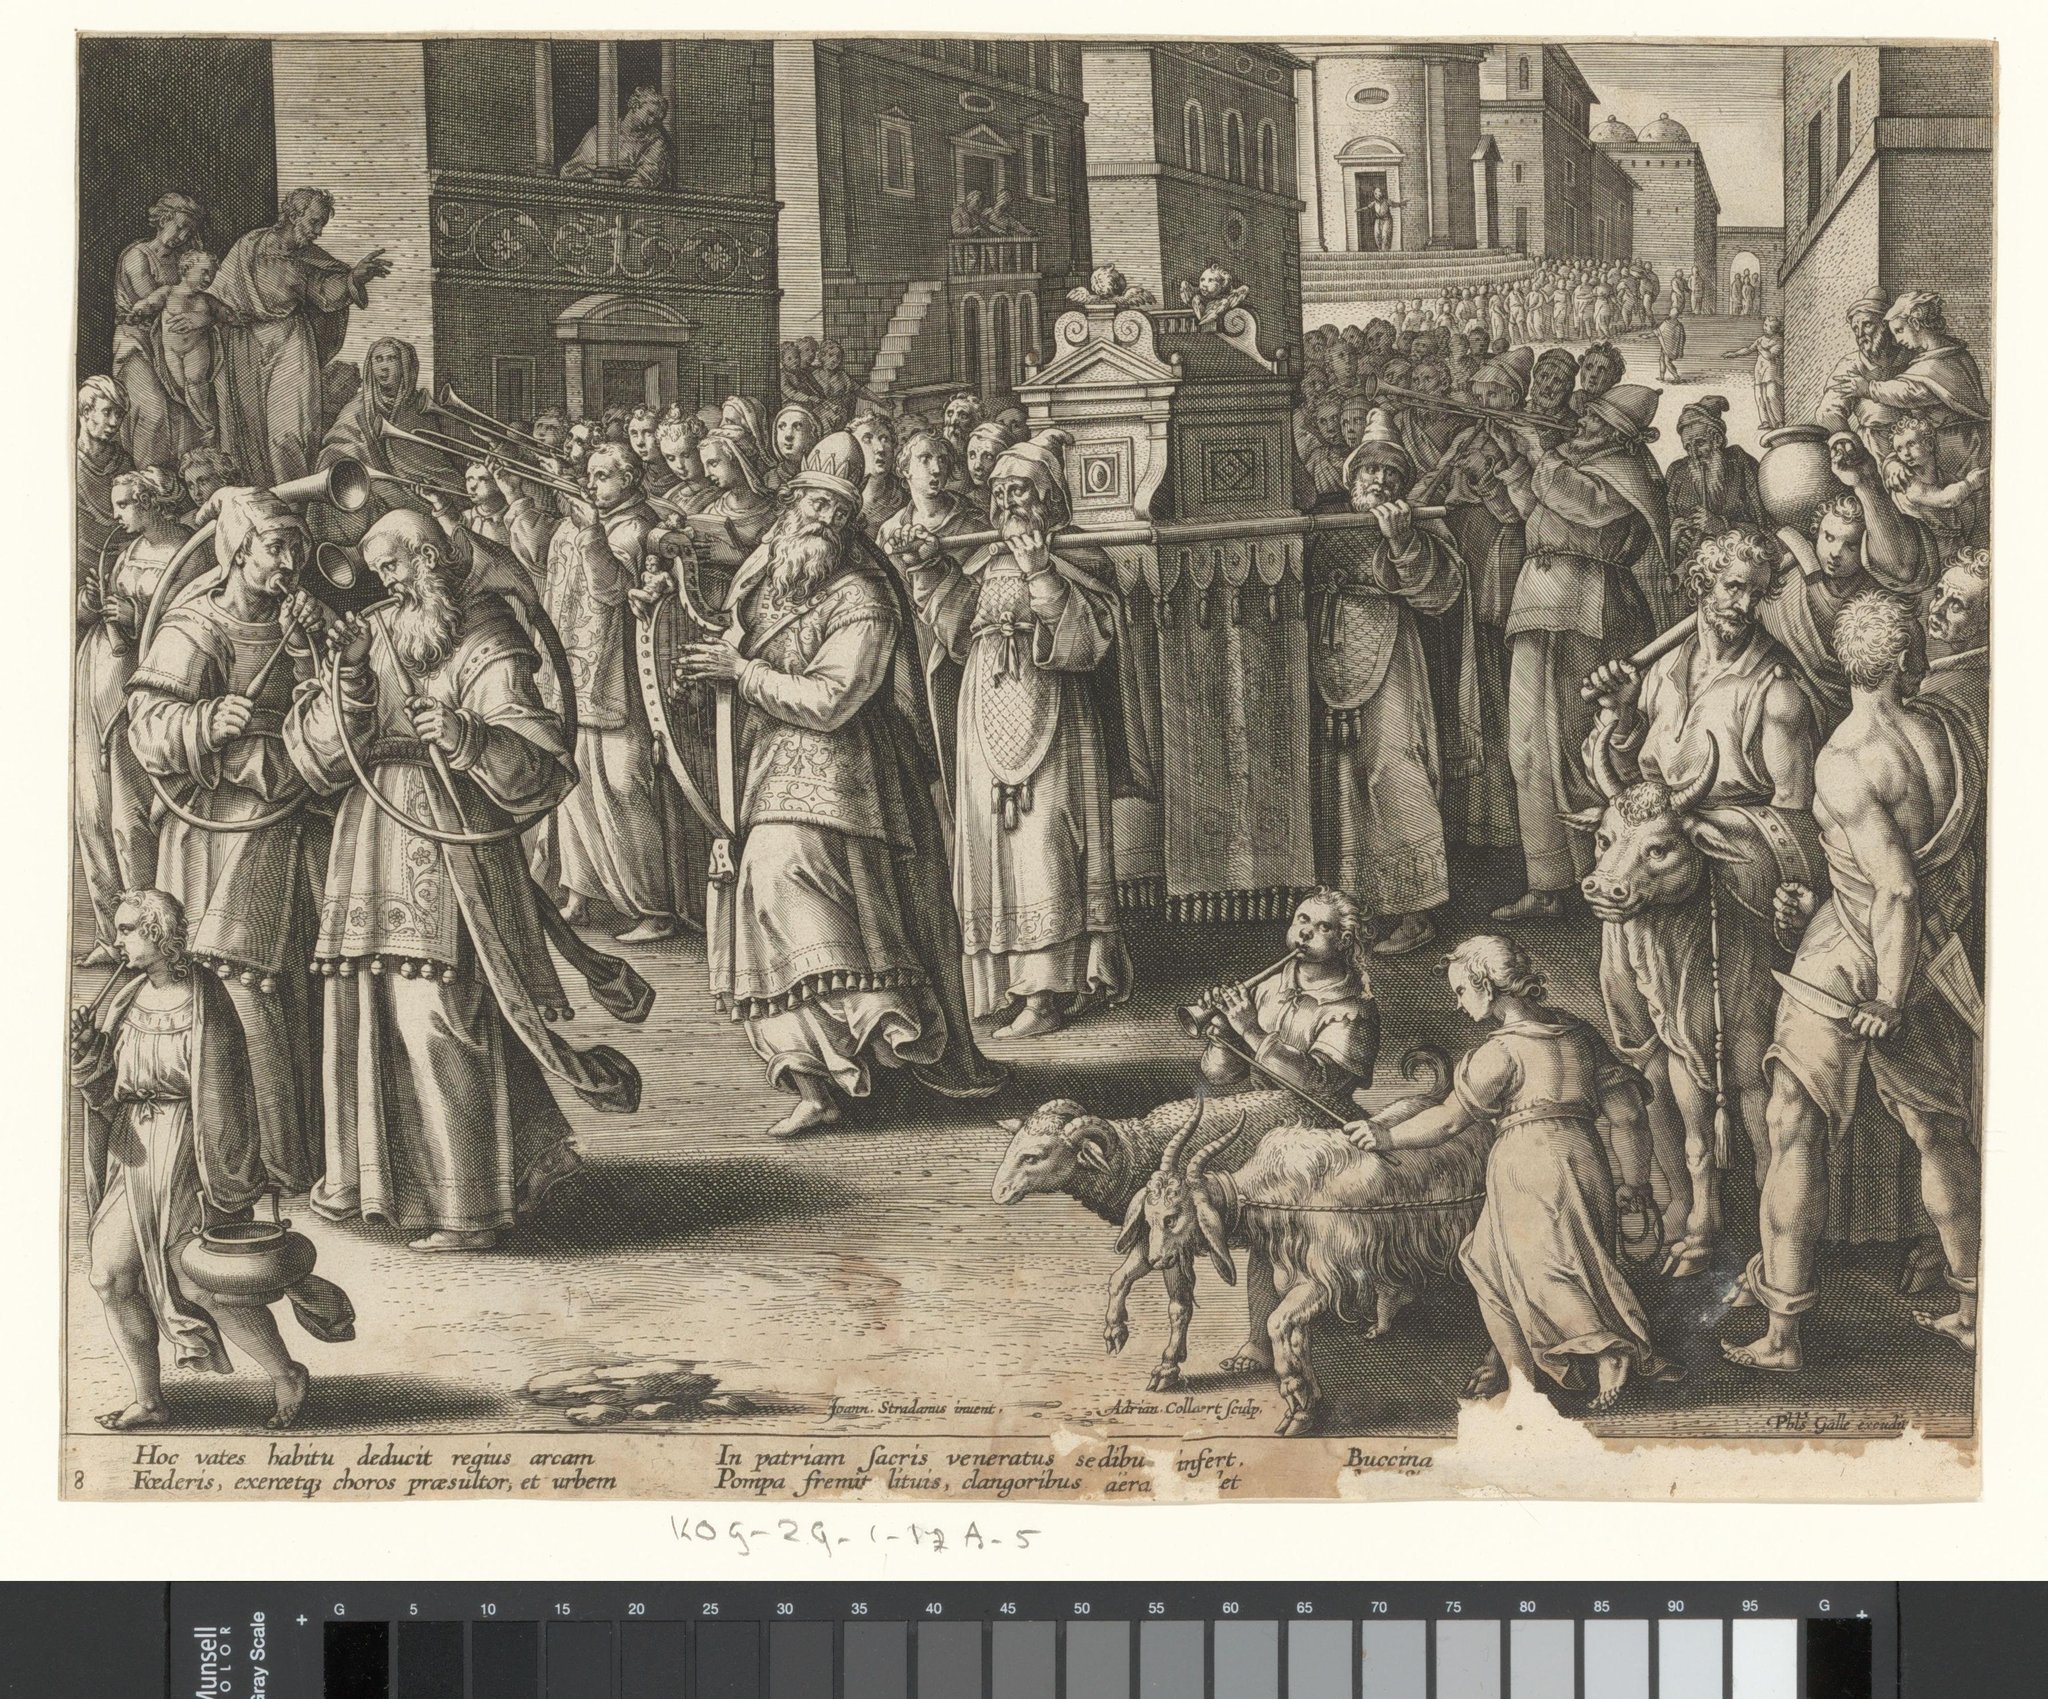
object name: print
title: Ark des Verbonds naar Jeruzalem gebracht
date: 1587-1592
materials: paper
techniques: engraving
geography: antwerp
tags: musical instruments; group of musical instruments, david brings the ark into jerusalem, dancing (half-)naked before the ark and making music, while the people rejoice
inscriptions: collector's mark: Lugt 1641, stamp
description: De Ark des Verbonds wordt Jeruzalem binnengedragen. Koning David loopt voor de Ark en speelt op zijn harp. Anderen Israëlieten blazen op bazuinen en hoorns. Rechts een ram, geit en stier. De prent heeft een Latijns onderschrift met verzen. Rechtsonder een verwijzing naar 2. Samuël 6. Linksonder genummerd: 8. Onderwerpsrubrieken binnen de Atlas Zeden en Gewoonten: Muziek en muziekinstrumenten: Muziekinstrumenten op bijbelprenten.